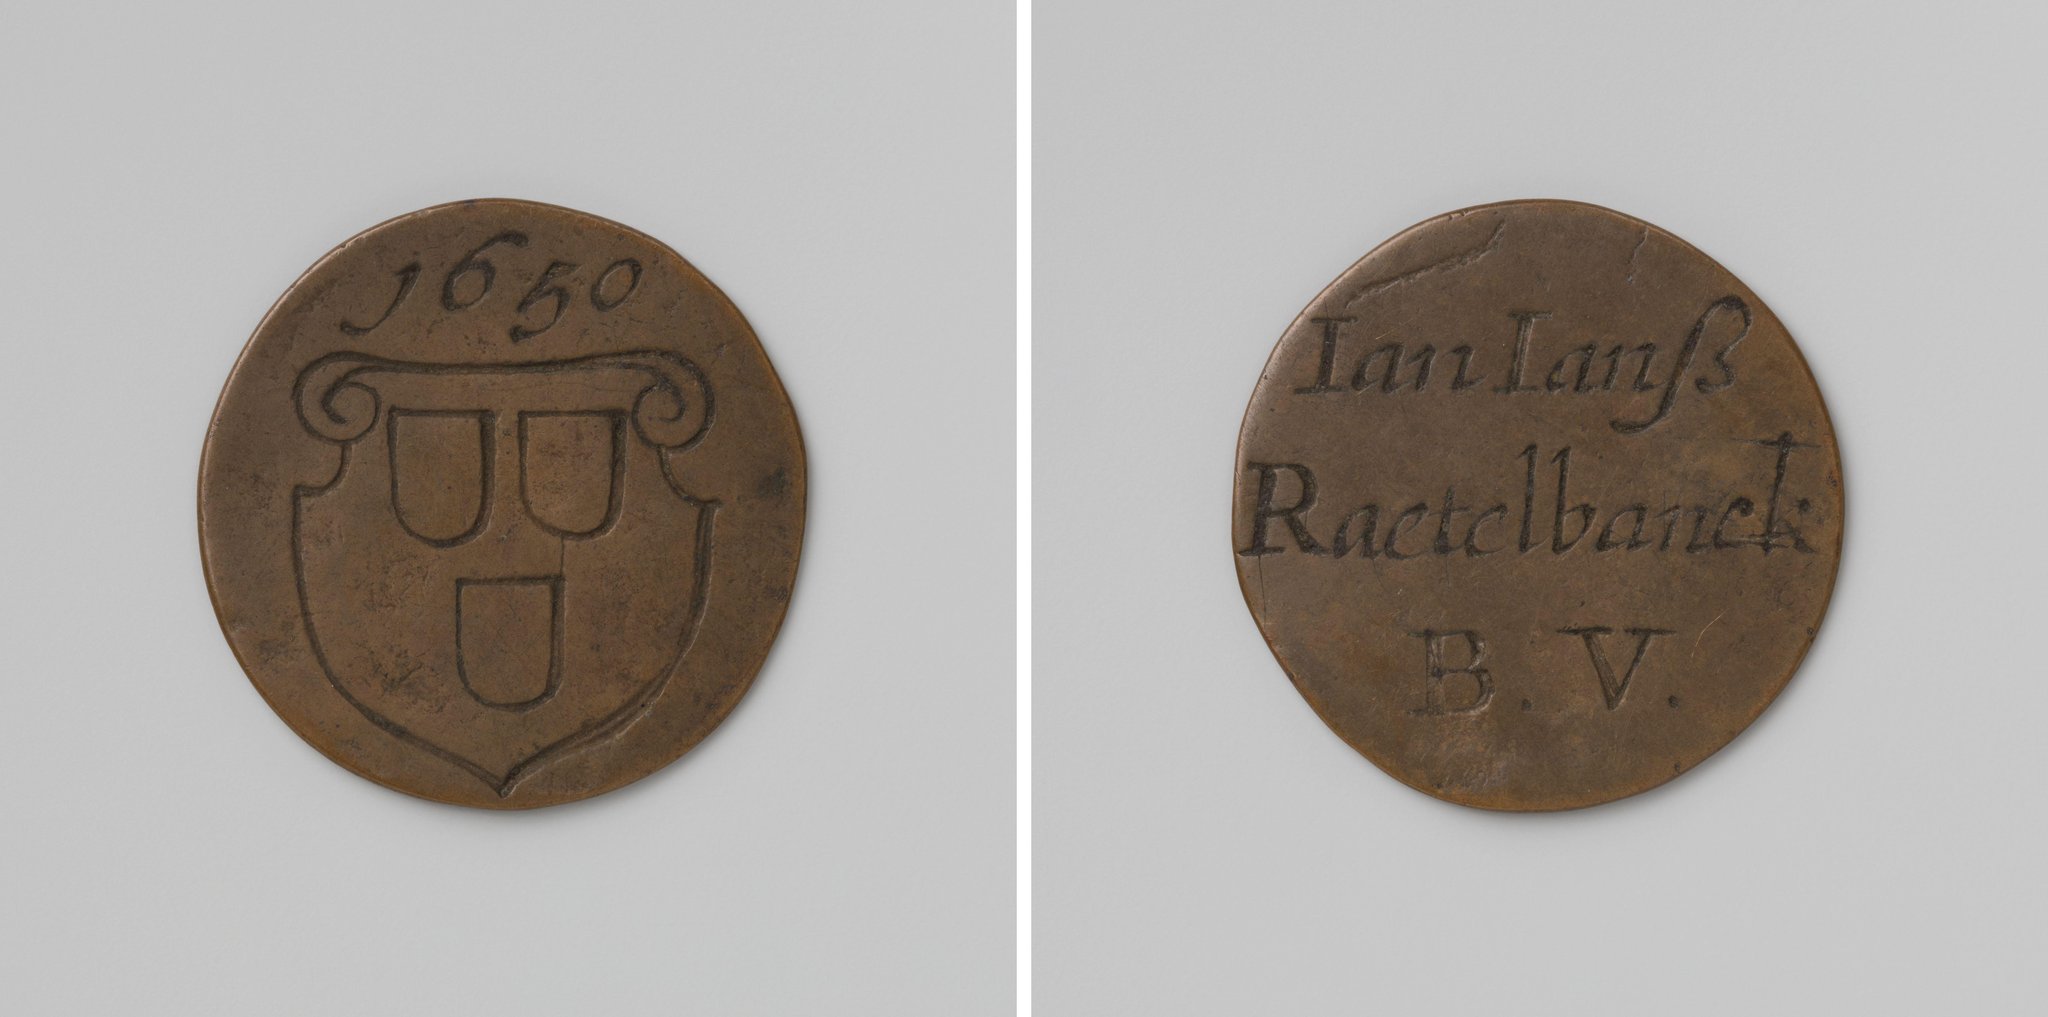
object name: medal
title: St. Lucasgilde van Amsterdam, gildepenning van Jan Jansz Raetelbanck, boekverkoper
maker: Anonymous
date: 1650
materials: copper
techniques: engraving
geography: amsterdam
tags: amsterdam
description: Koperen penning. Voorzijde: Lucasschild onder jaartal. Keerzijde: opschrift